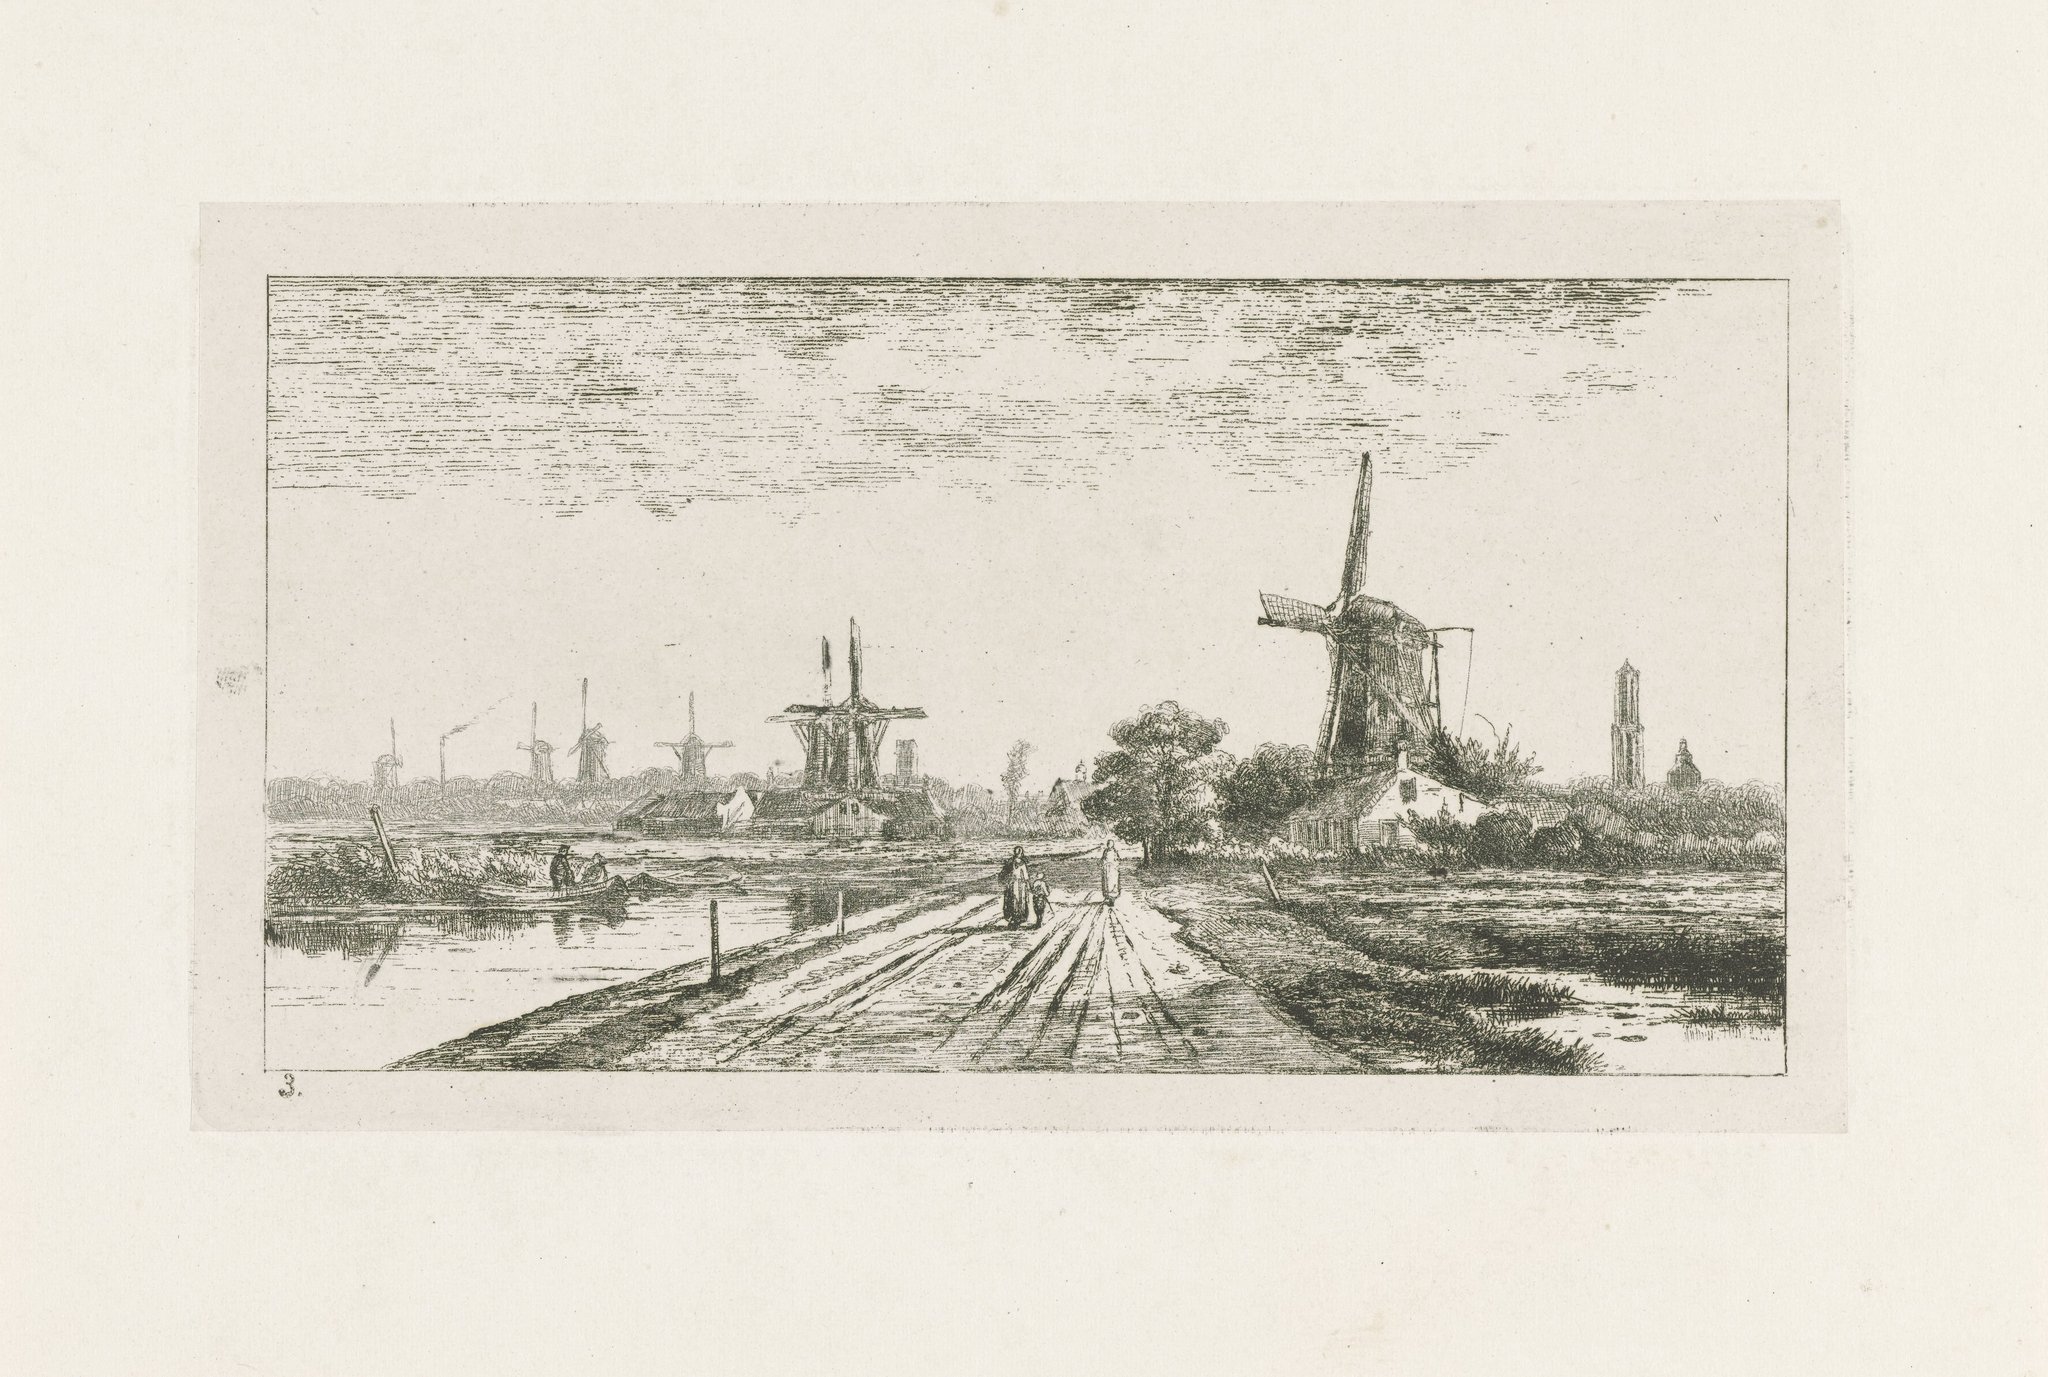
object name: print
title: Omstreken van Utrecht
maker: jan van lokhorst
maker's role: draughtsman, print maker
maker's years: 1837-1894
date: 1858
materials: paper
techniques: etching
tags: windmill in landscape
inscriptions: collector's mark: Lugt 2228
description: Landschap met molens, op de weg lopen drie figuren.